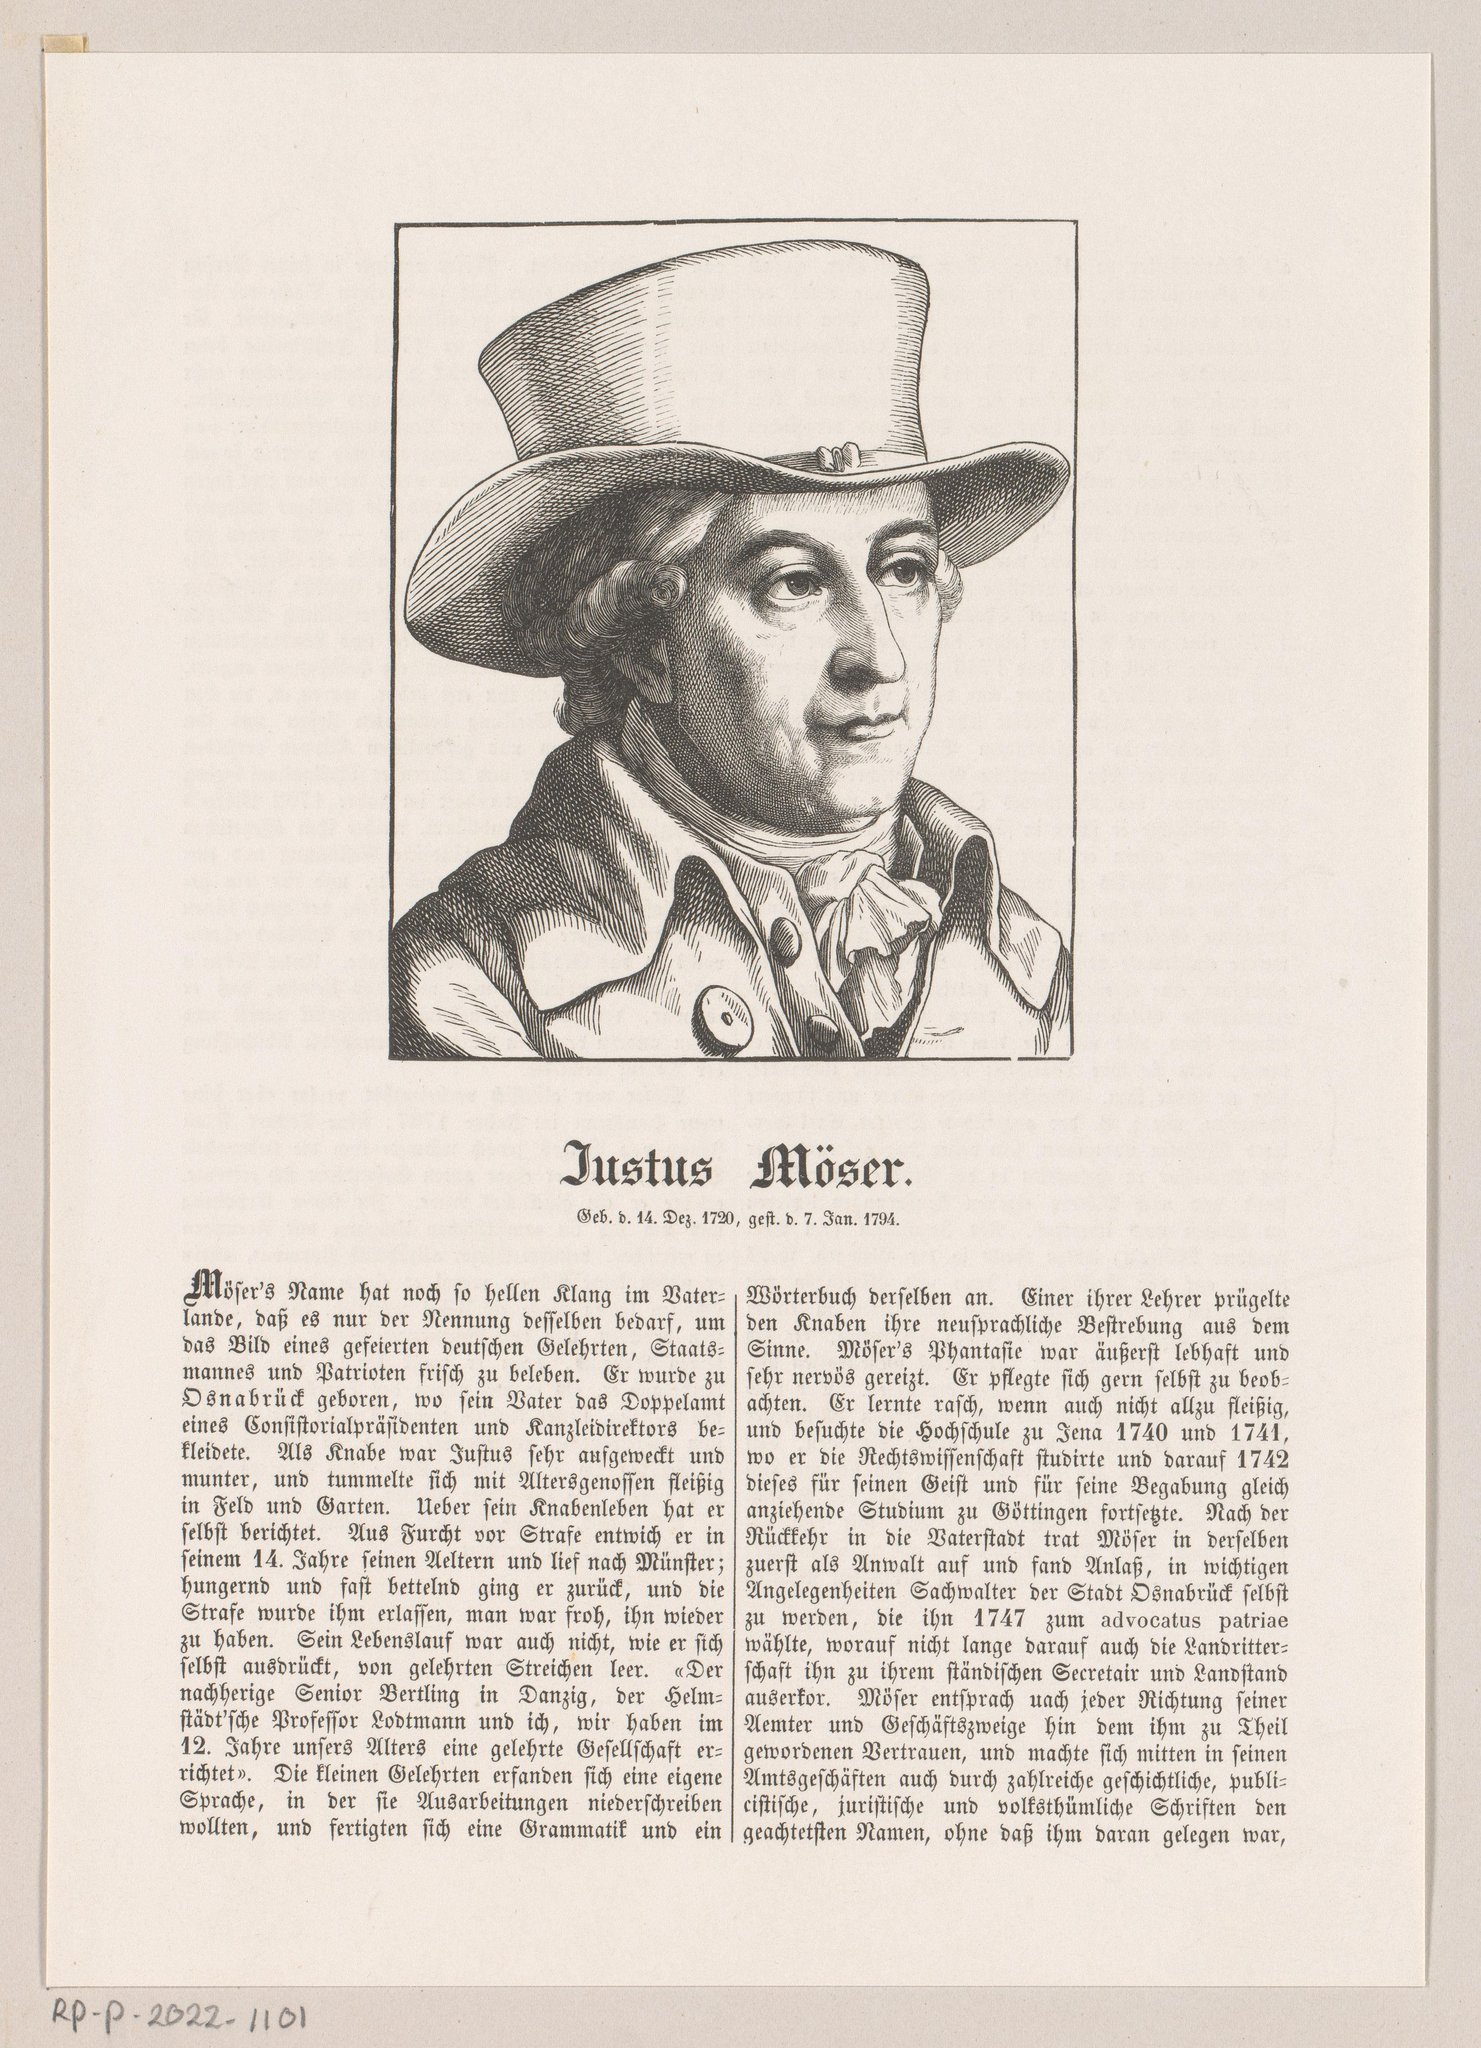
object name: print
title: Portret van Justus Möser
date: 1854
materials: paper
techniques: letterpress printing, engraving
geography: leipzig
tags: historical persons, lawyer, attorney at law, portrait of a writer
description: Bladzijde uit: Bechstein, Ludwig. Zweihundert deutsche Männer in Bildnissen und Lebensbeschreibungen. Leipzig: Georg Wigand, 1854. Prent met andere tekst gebruikt in: Gaedertz, Karl Theodor. Dreihundert Bildnisse und Lebensabrisse berühmter deutscher Männer. Leipzig: Georg Wigand, 1890. Bij de uitgave uit 1890 staat op de titelpagina vermeld dat de prenten zijn gemaakt door Hugo Bürkner.